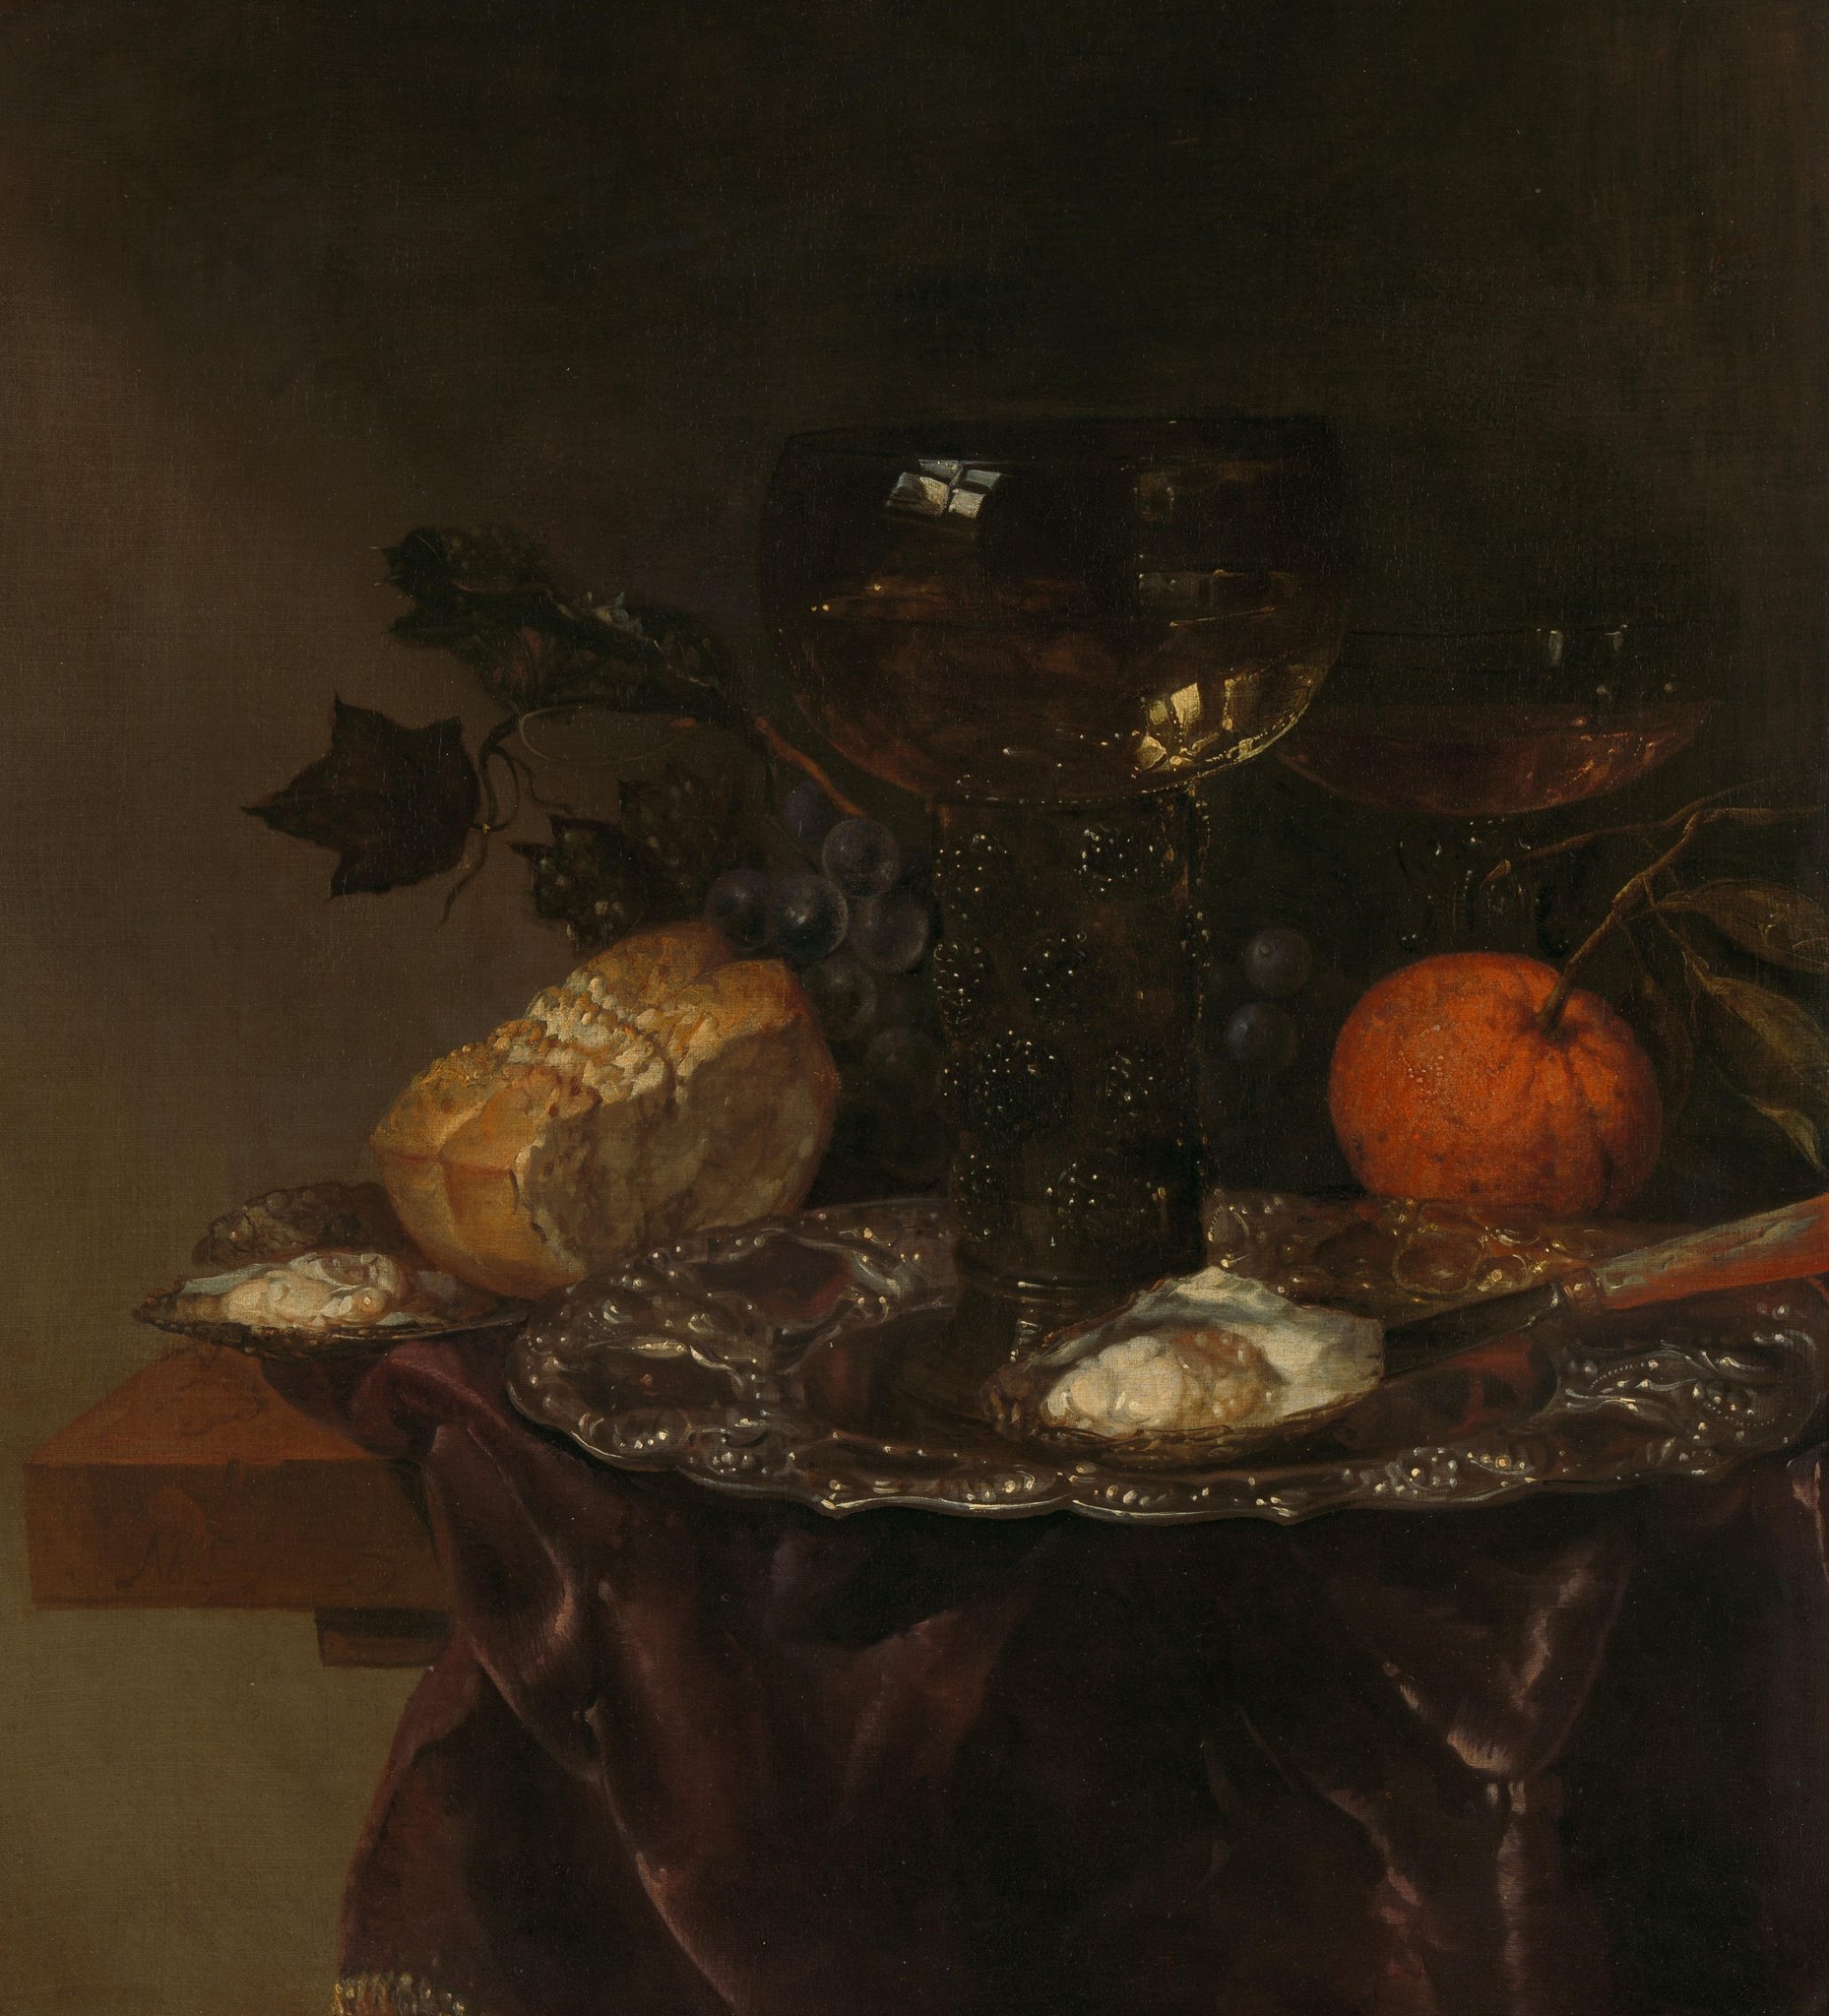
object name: painting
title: Still Life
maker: abraham van beyeren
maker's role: painter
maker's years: 1620-1690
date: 1660-1690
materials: canvas, oil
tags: molluscs: oyster, glass, rummer, laid table as still life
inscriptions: signature, with ligated monogram, lower left, on the edge of the table: ‘AVB f.’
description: Abraham van Beyeren (1620/21 - 1690). Still life.